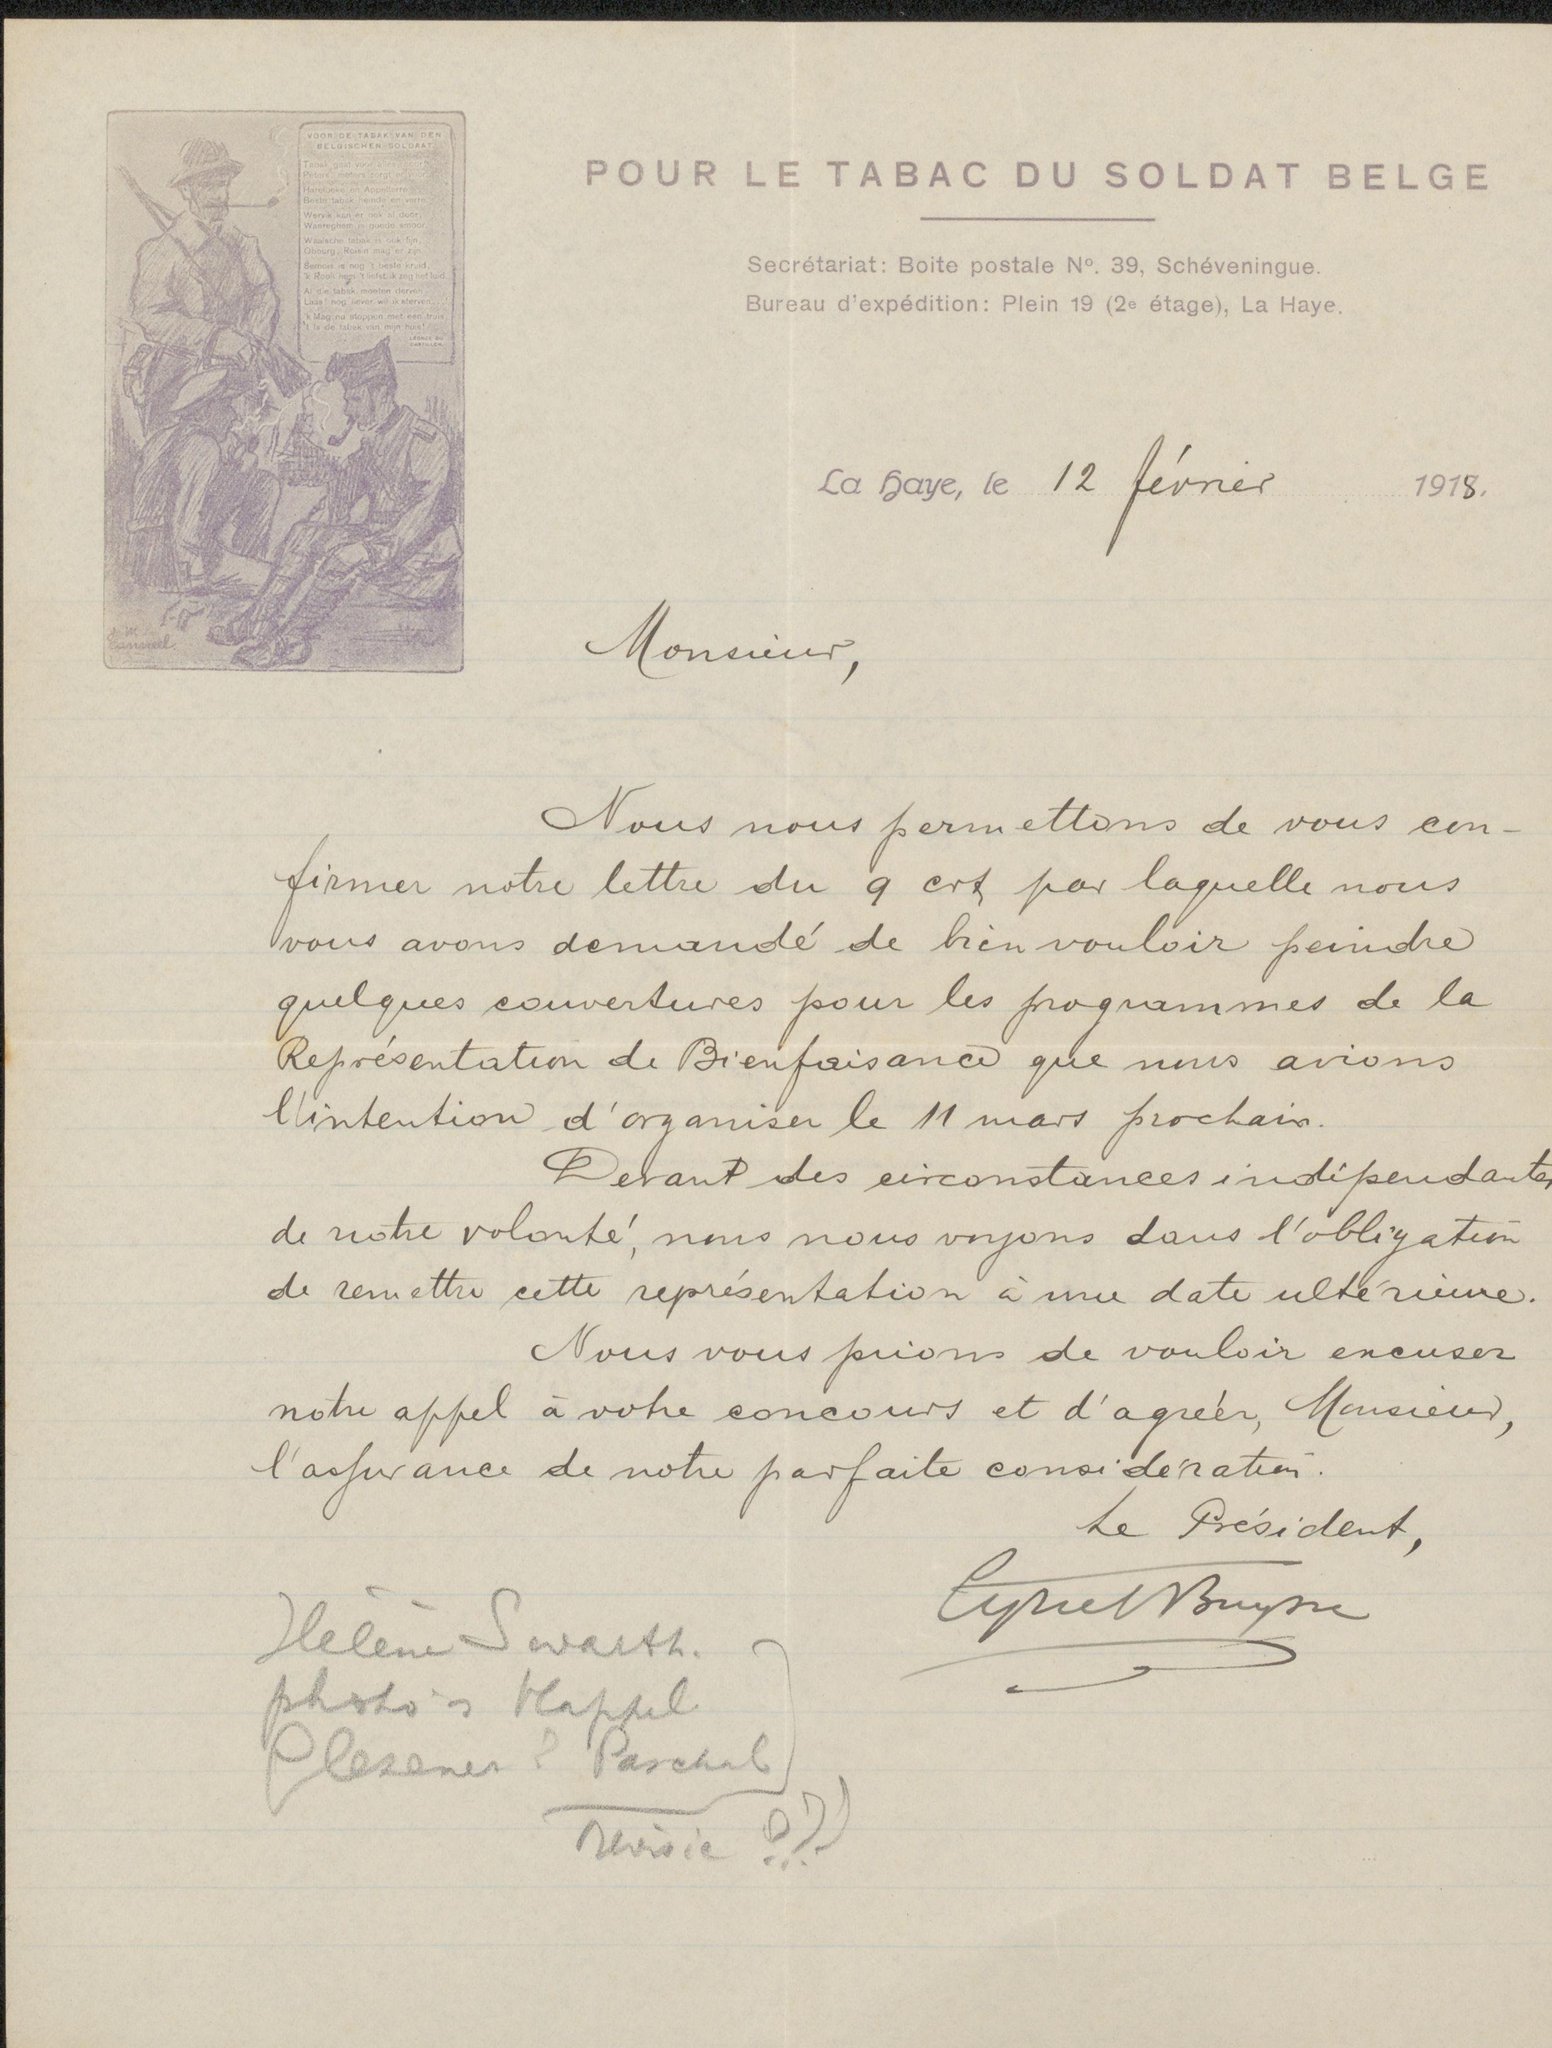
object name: letter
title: Brief aan Philip Zilcken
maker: cyriel buysse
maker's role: schrijver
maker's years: 1859-1932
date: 1918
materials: ink, pencil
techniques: pen, printing, writing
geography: the hague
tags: the hague, painter, draughtsman, philip zilcken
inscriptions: collector's mark: ‘RPK’